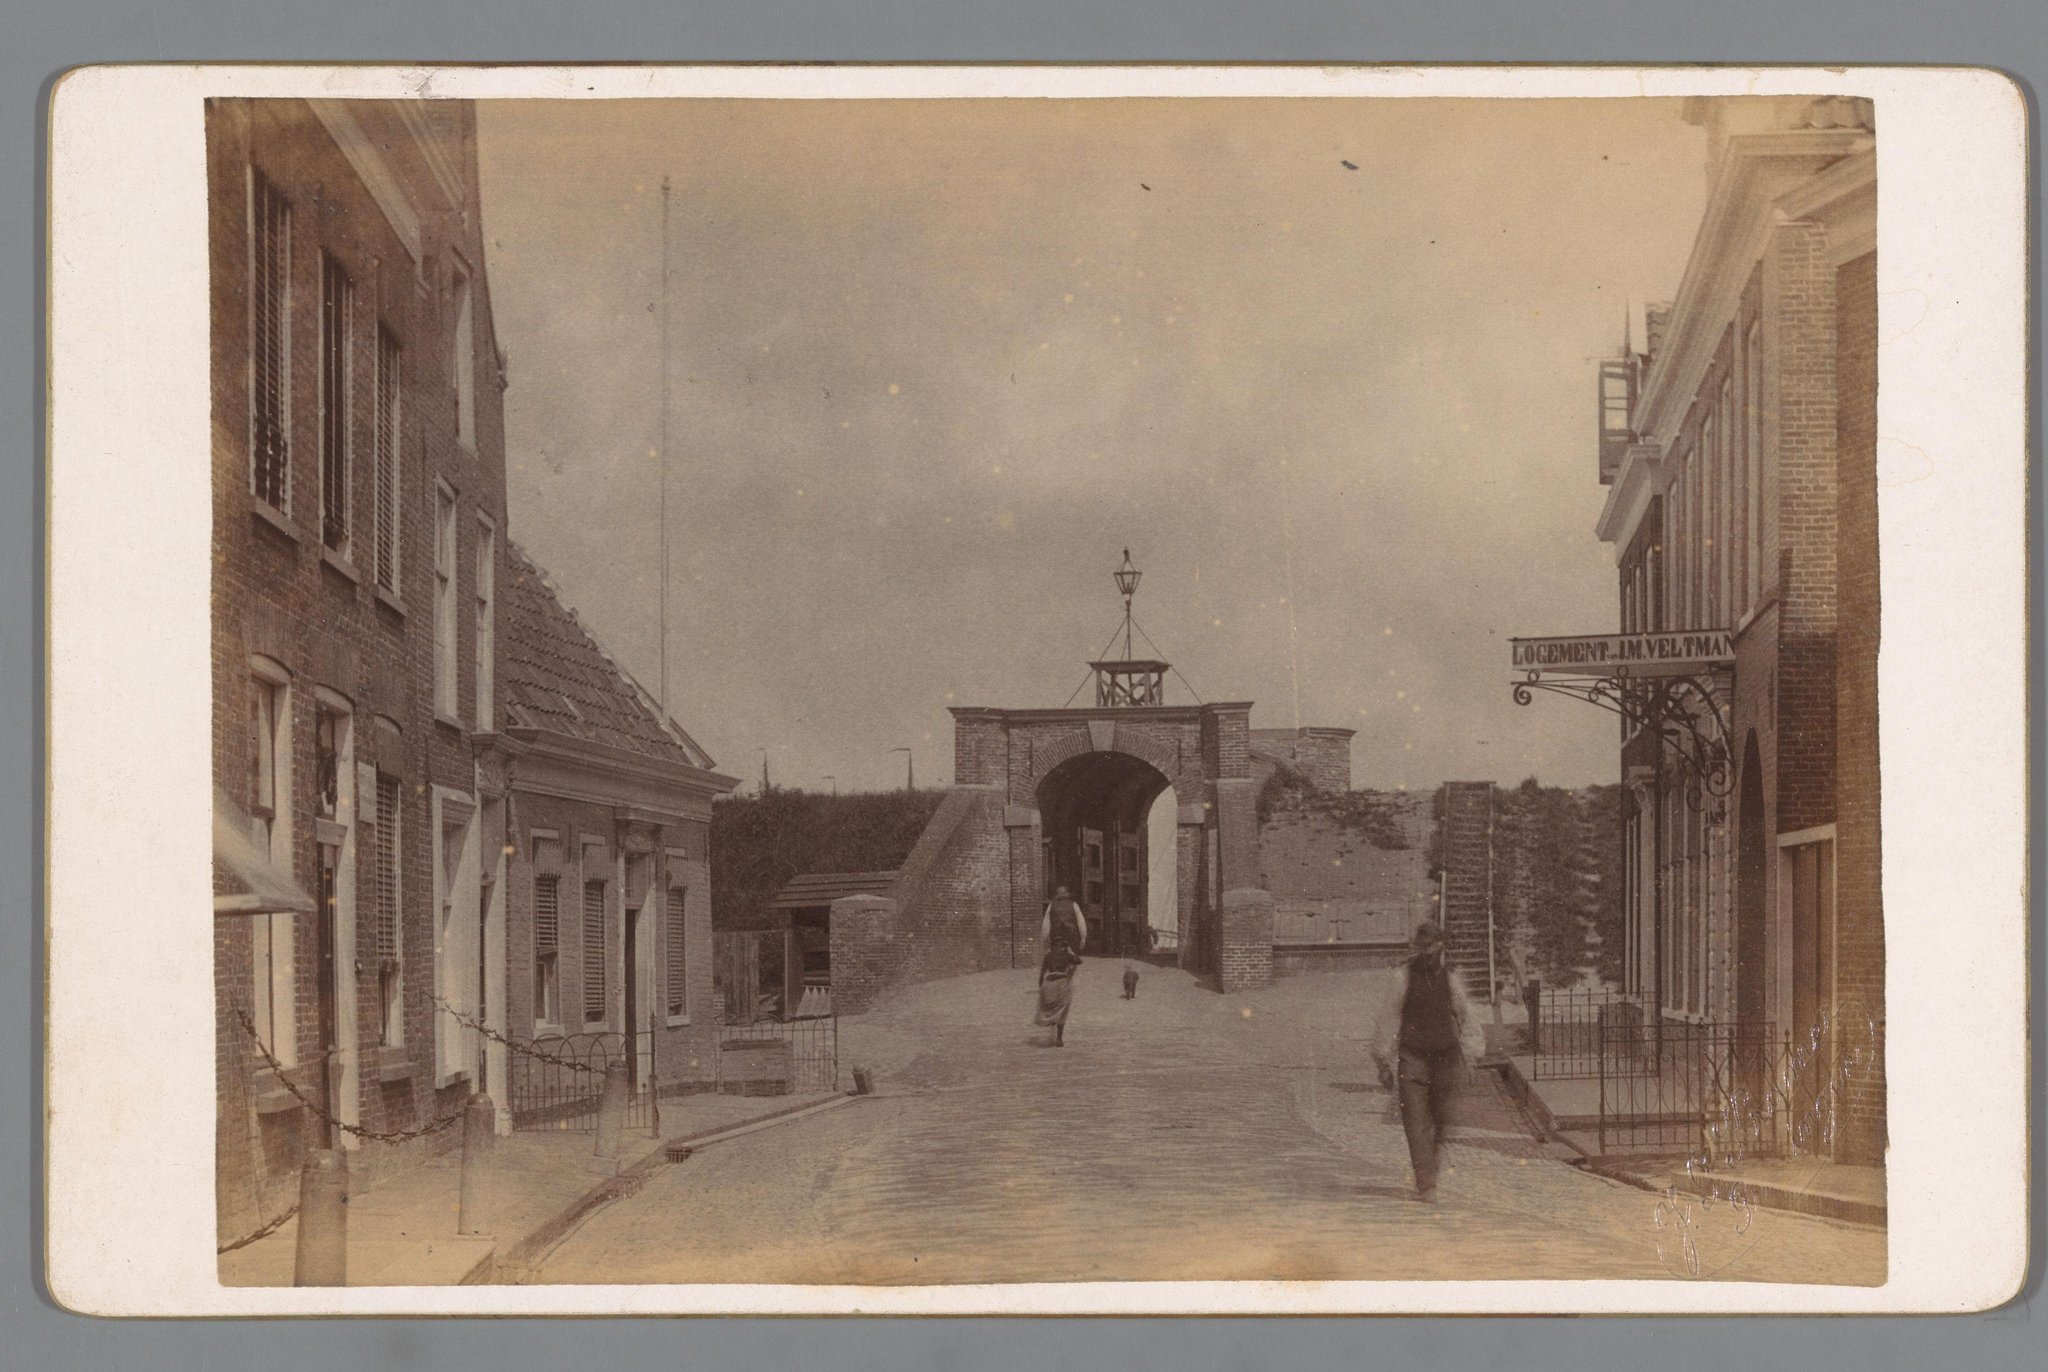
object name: photograph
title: Straat naar de Grote Waterpoort te Delfzijl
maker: johannes gerardus kramer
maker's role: fotograaf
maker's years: 1845-1903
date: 1895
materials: cardboard, photographic support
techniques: albumen print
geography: delfzijl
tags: street, city-gate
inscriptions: name: ‘J. G. Kramer’, inscription: ‘Poort van Delfzijl 20 Aug. 1895 prov Groningen’